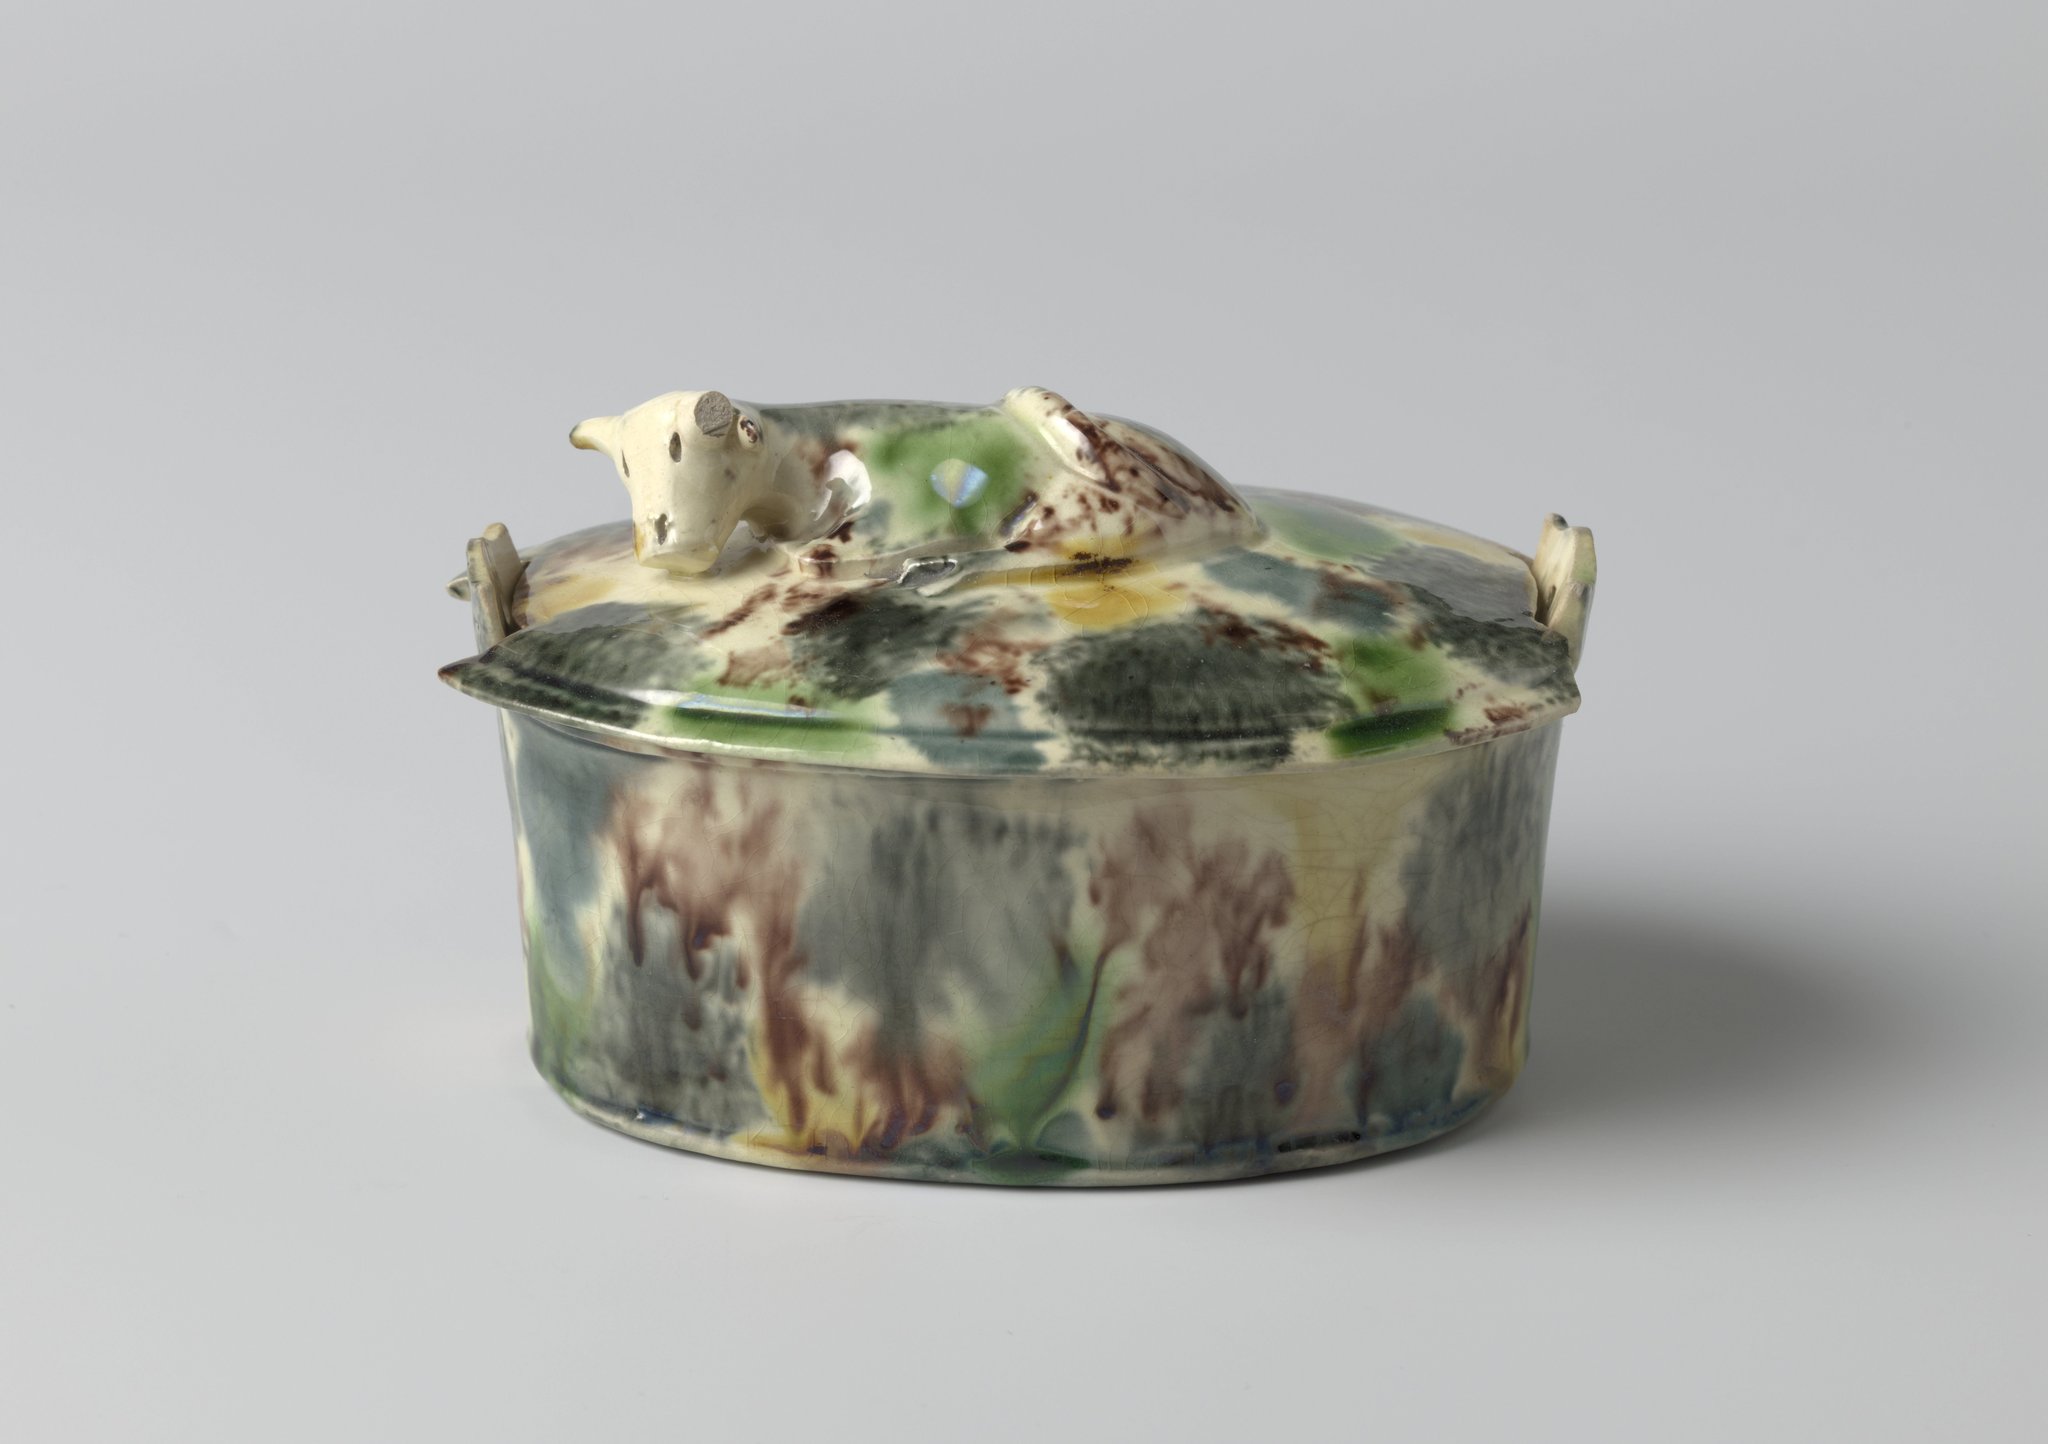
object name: butter dish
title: Deksel van een botervloot, van veelkleurig gebakken aardewerk; Staffordshire.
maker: Anonymous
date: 1750-1770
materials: earthenware, glaze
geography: england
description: Deksel (ovaal?) van veelkleurig hardgebakken aardewerk. Het deksel heeft een knop in de vorm van een liggende koe. Het deksel hoort bij een botervloot die ontbreekt en een onderschotel (BK-1987-36-B).